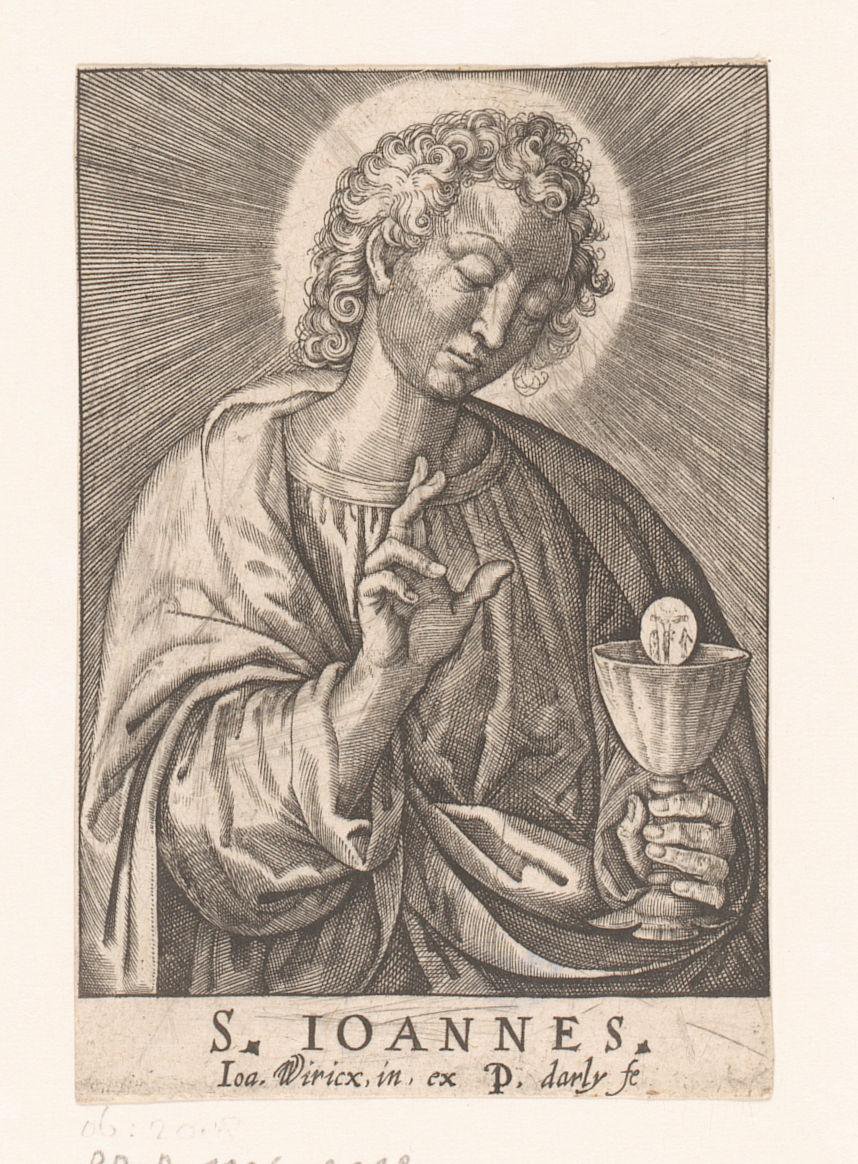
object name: print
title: S. Joannes.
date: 1559-1618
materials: paper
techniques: engraving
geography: antwerp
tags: the apostle john the evangelist; possible attributes: book, cauldron, chalice with snake, eagle, palm, scroll, chalice bearing the host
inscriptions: collector's mark: Lugt 2228, collector's mark: Lugt 1337